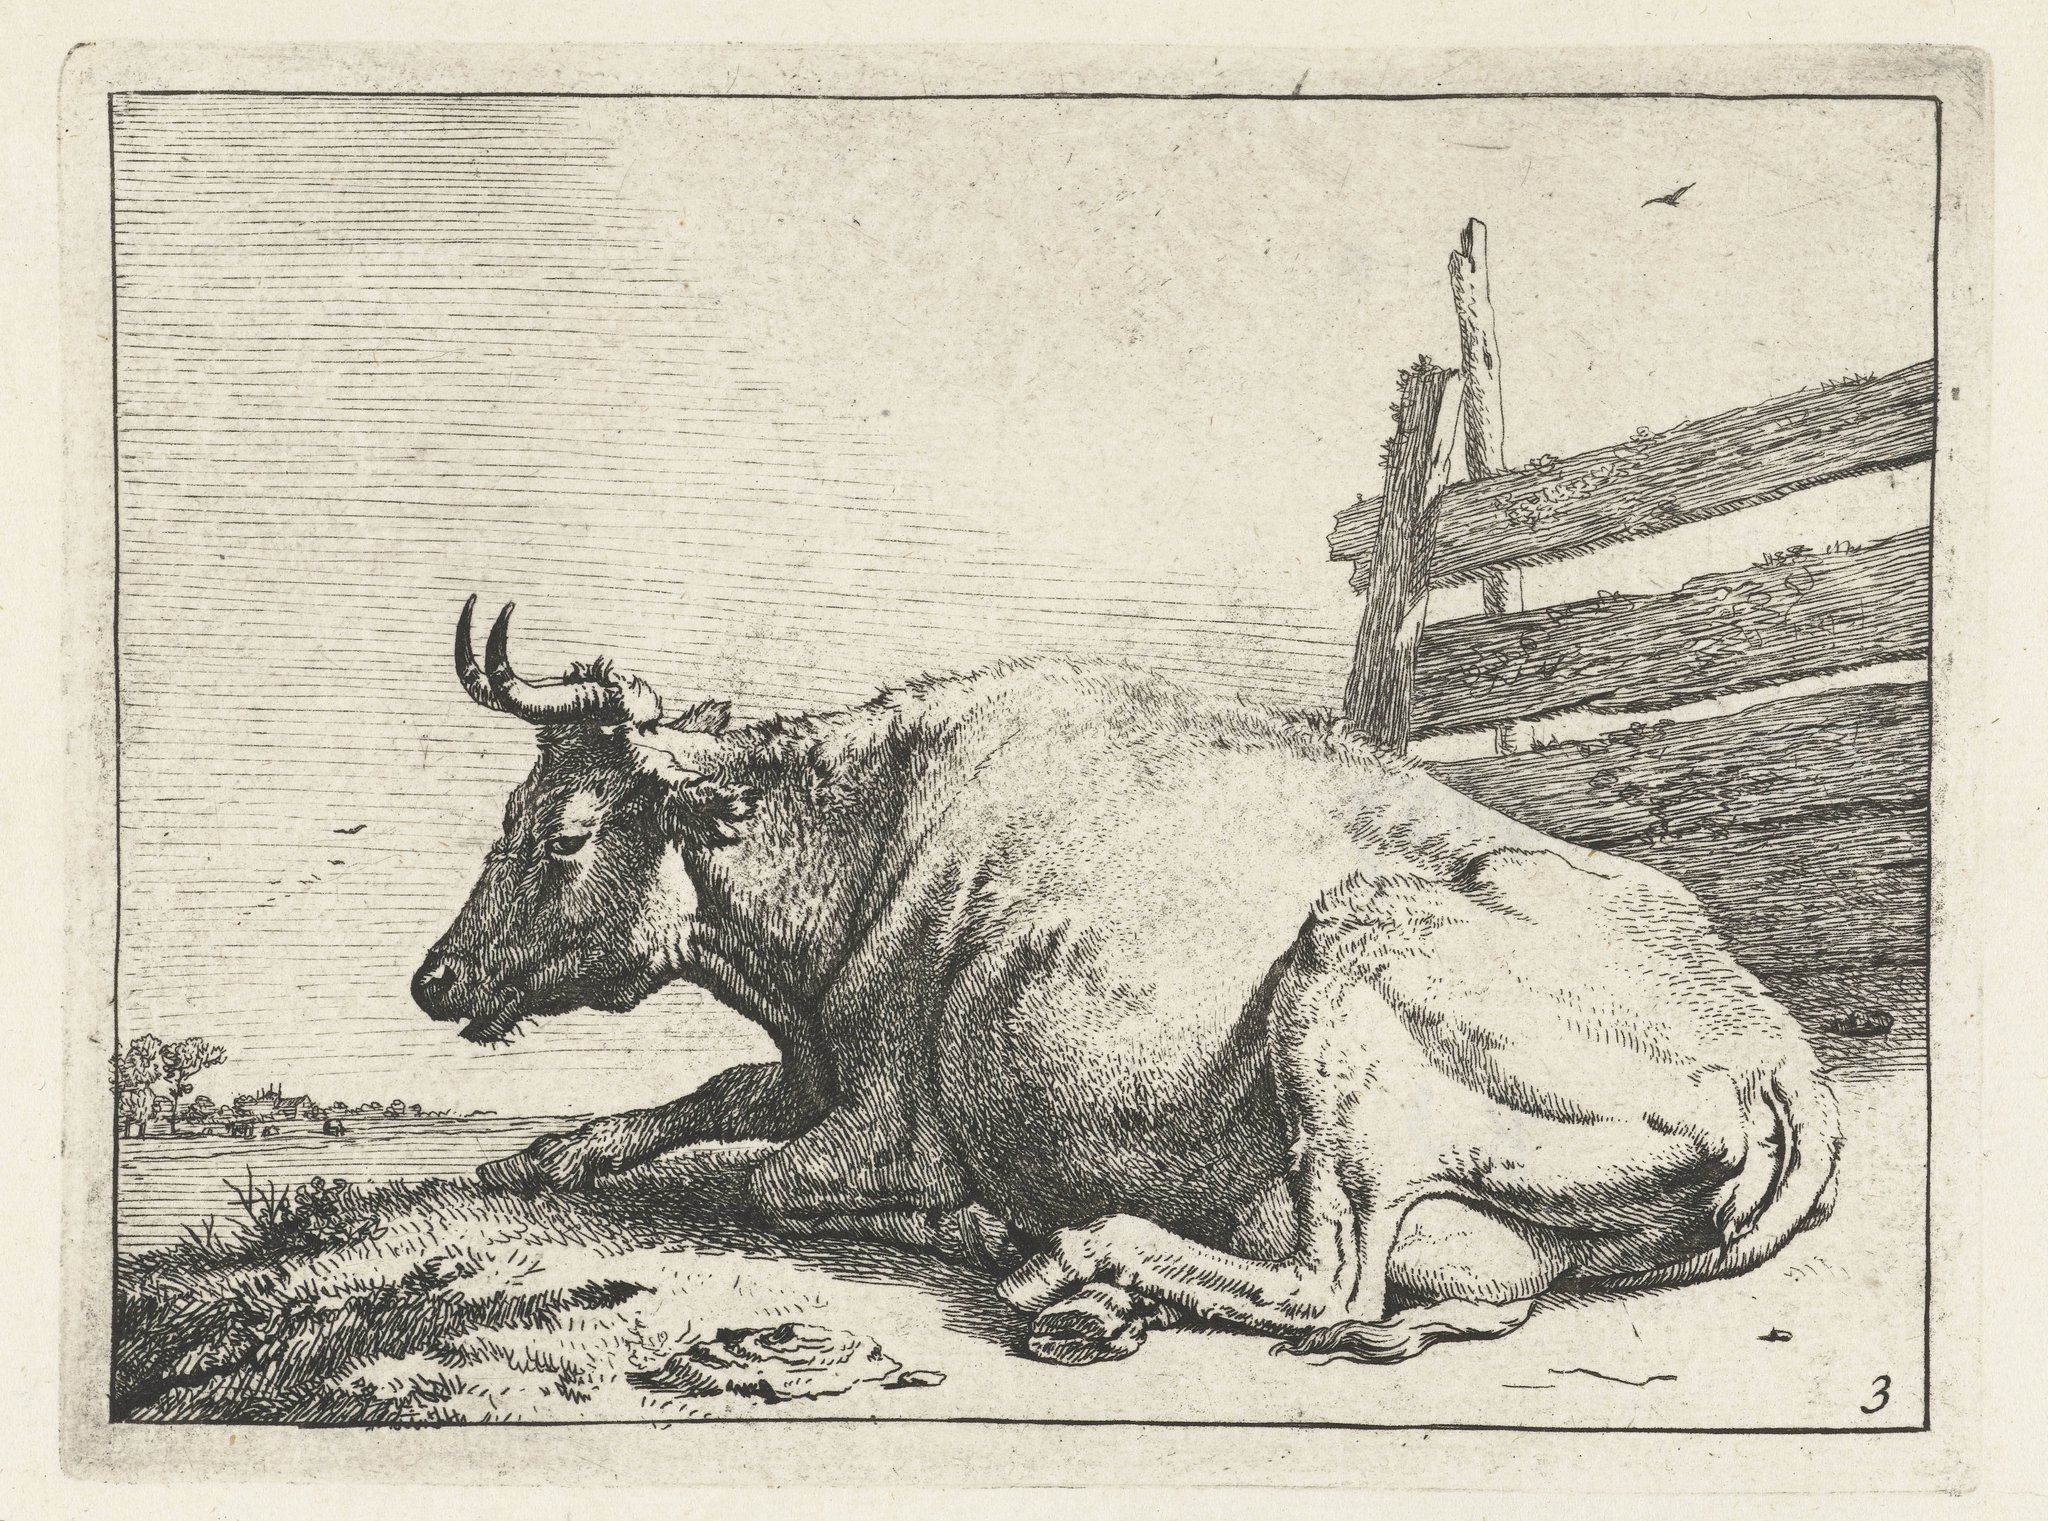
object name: print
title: Liggende koe bij een hek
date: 1650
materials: paper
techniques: etching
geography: netherlands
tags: cow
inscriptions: collector's mark: Lugt 2228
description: Opgewerkte delen die derde staat zou moeten hebben, hier niet goed zichtbaar. Prent zou daarom ook tweede staat kunnen zijn.